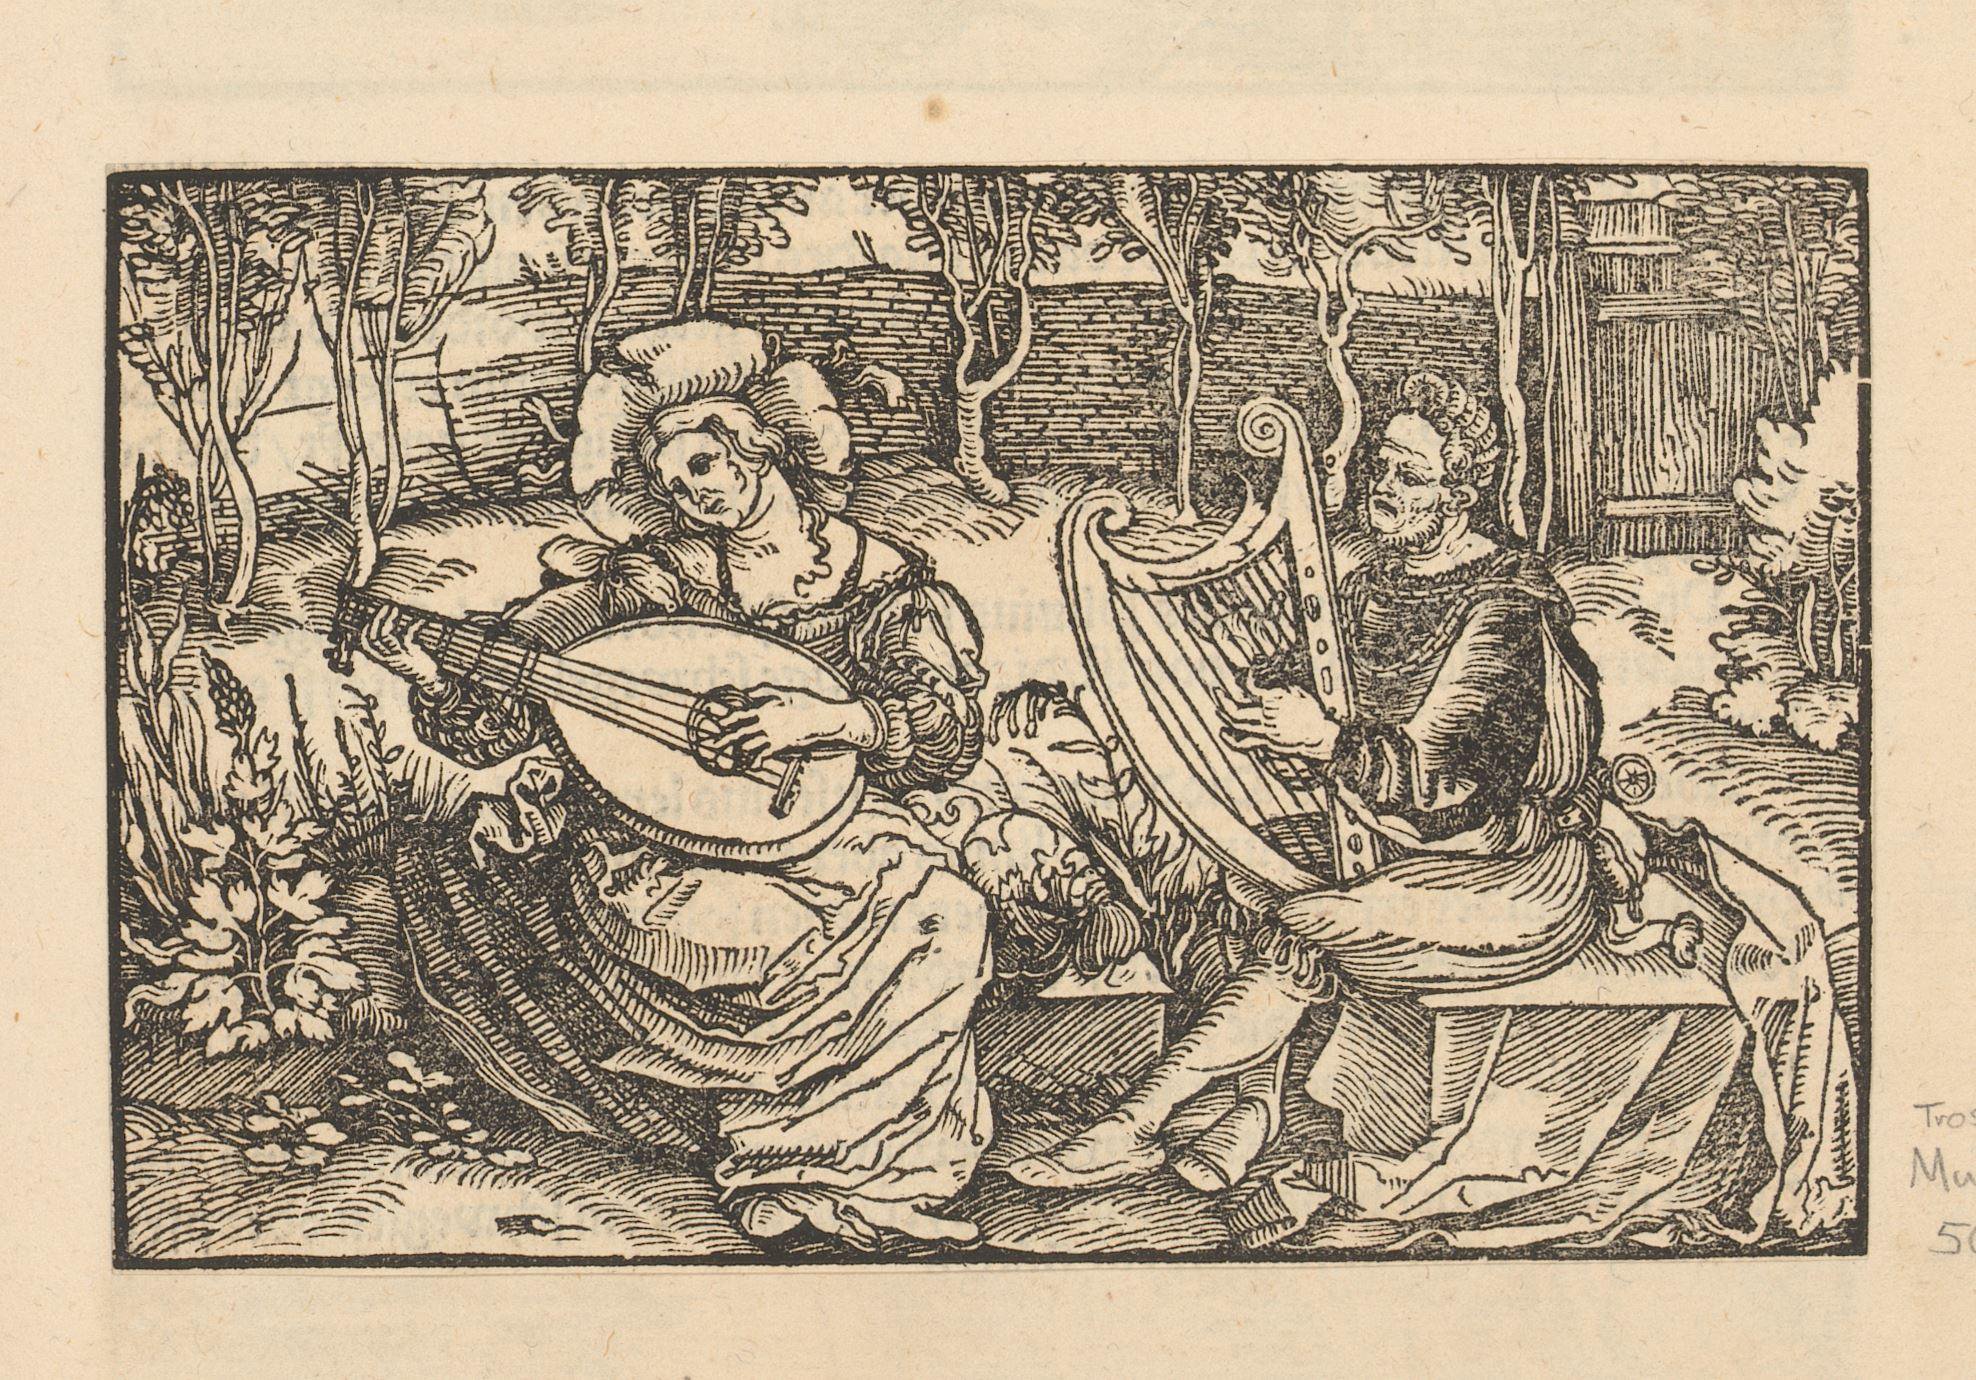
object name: print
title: Musicerend duo in een tuin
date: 1514-1532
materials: paper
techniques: letterpress printing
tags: more than one musician with instrument - cc - 'concert champêtre', harp, lute, and special forms of lute, e.g.: theorbo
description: Deze prent is gebruikt in: Cicero, Marcus Tulius. Officia M.T.C. Ein Buch so Marcus Tullius Cicero der Römer zu seynem (...). [Vertaald uit het Latijn door] Johann von Schwarzenberg. Augsburg: Heinrich Steiner, 1531.